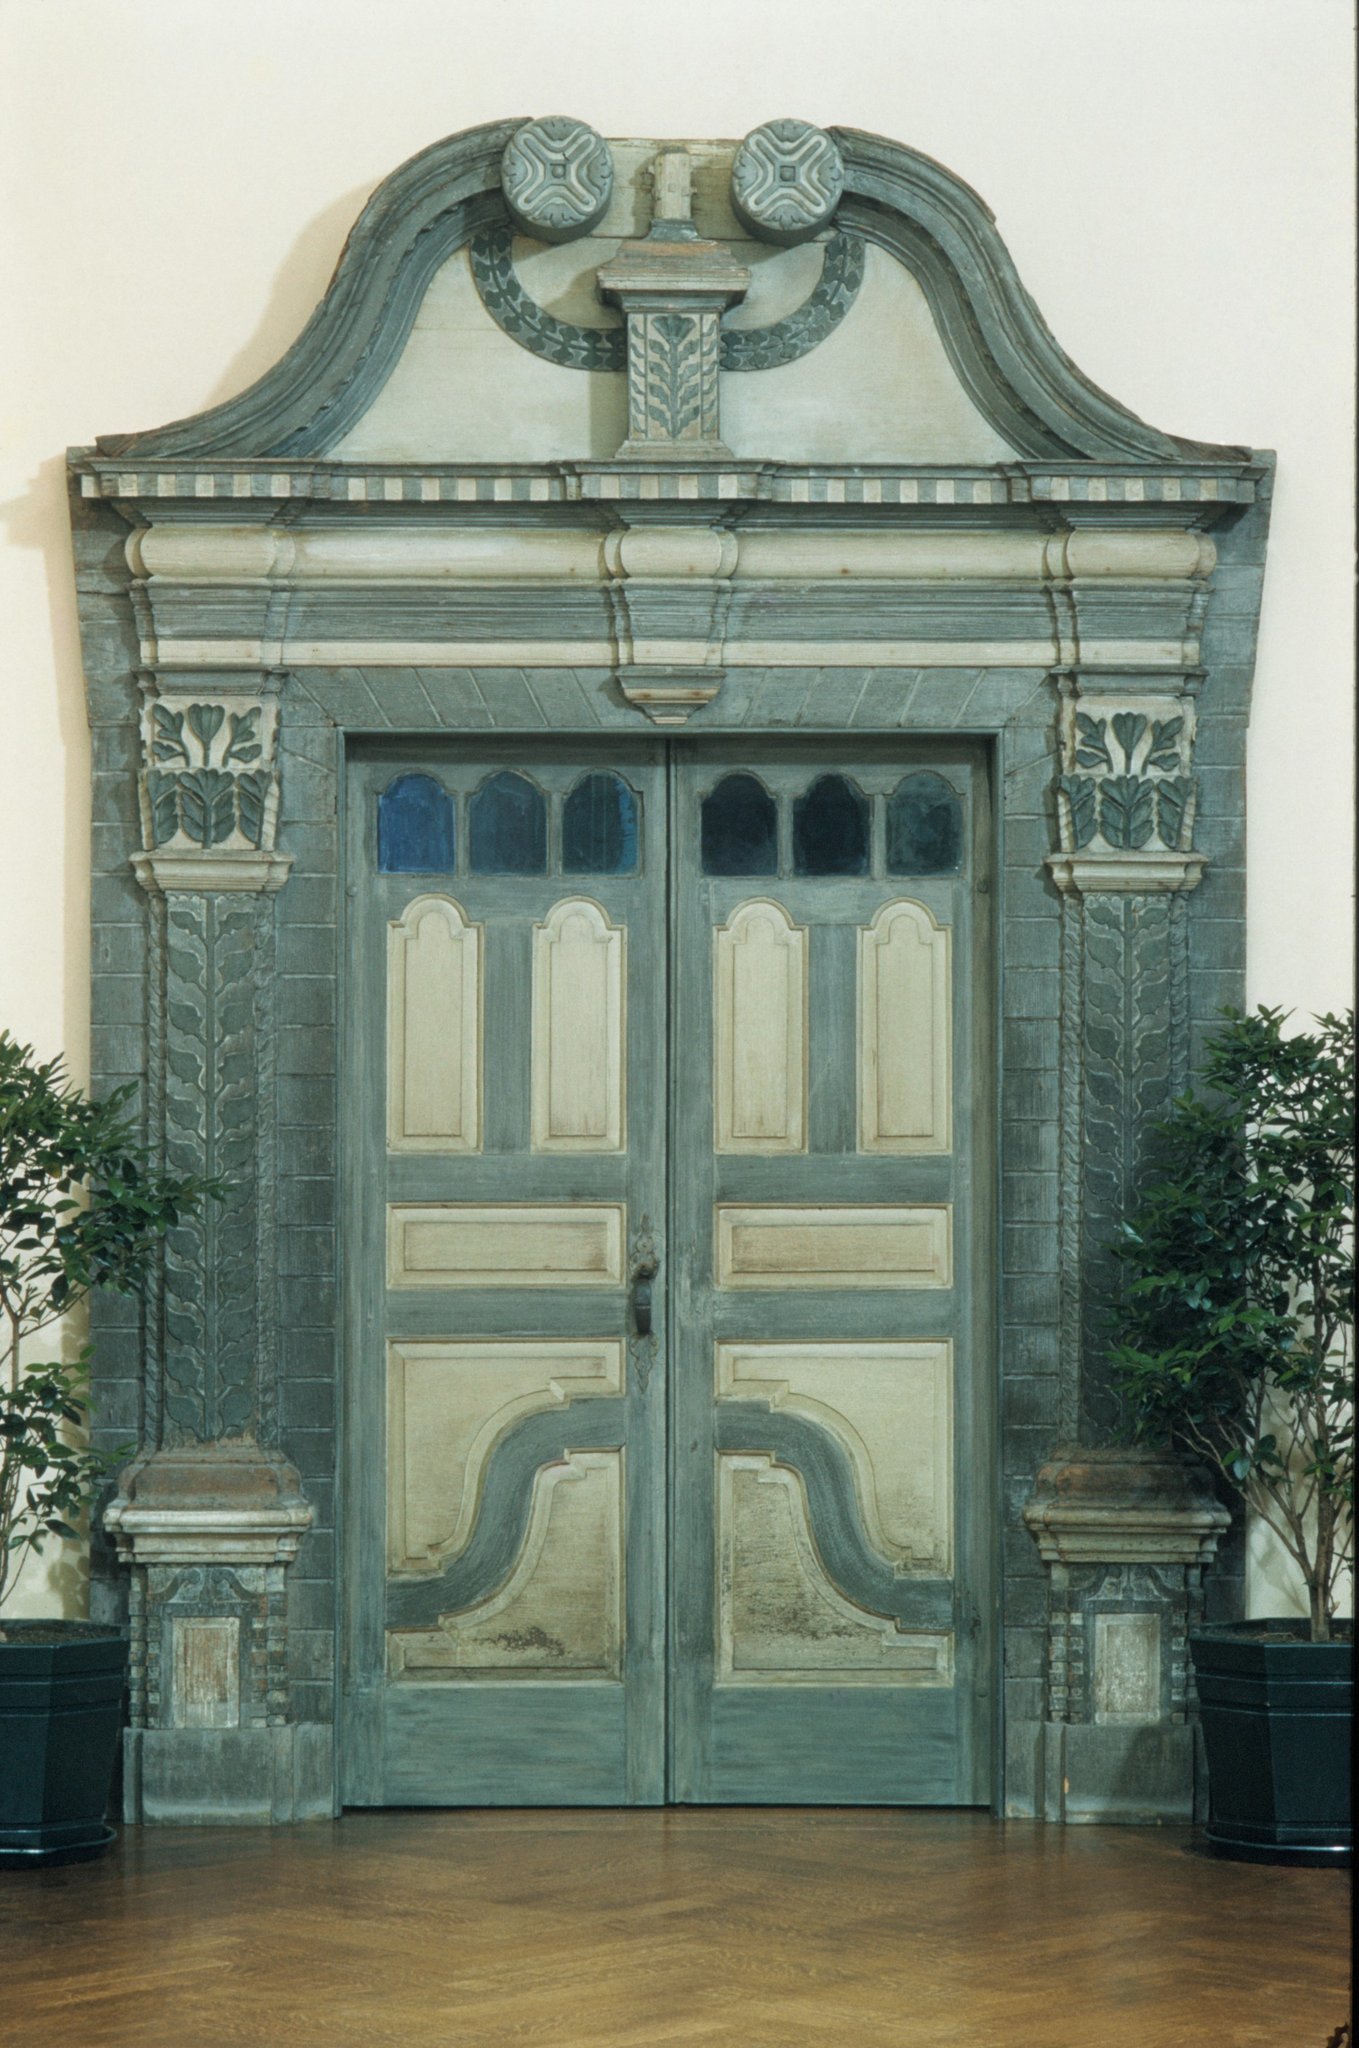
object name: doorway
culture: american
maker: alexander grant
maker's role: maker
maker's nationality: american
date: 1750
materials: wood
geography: united states